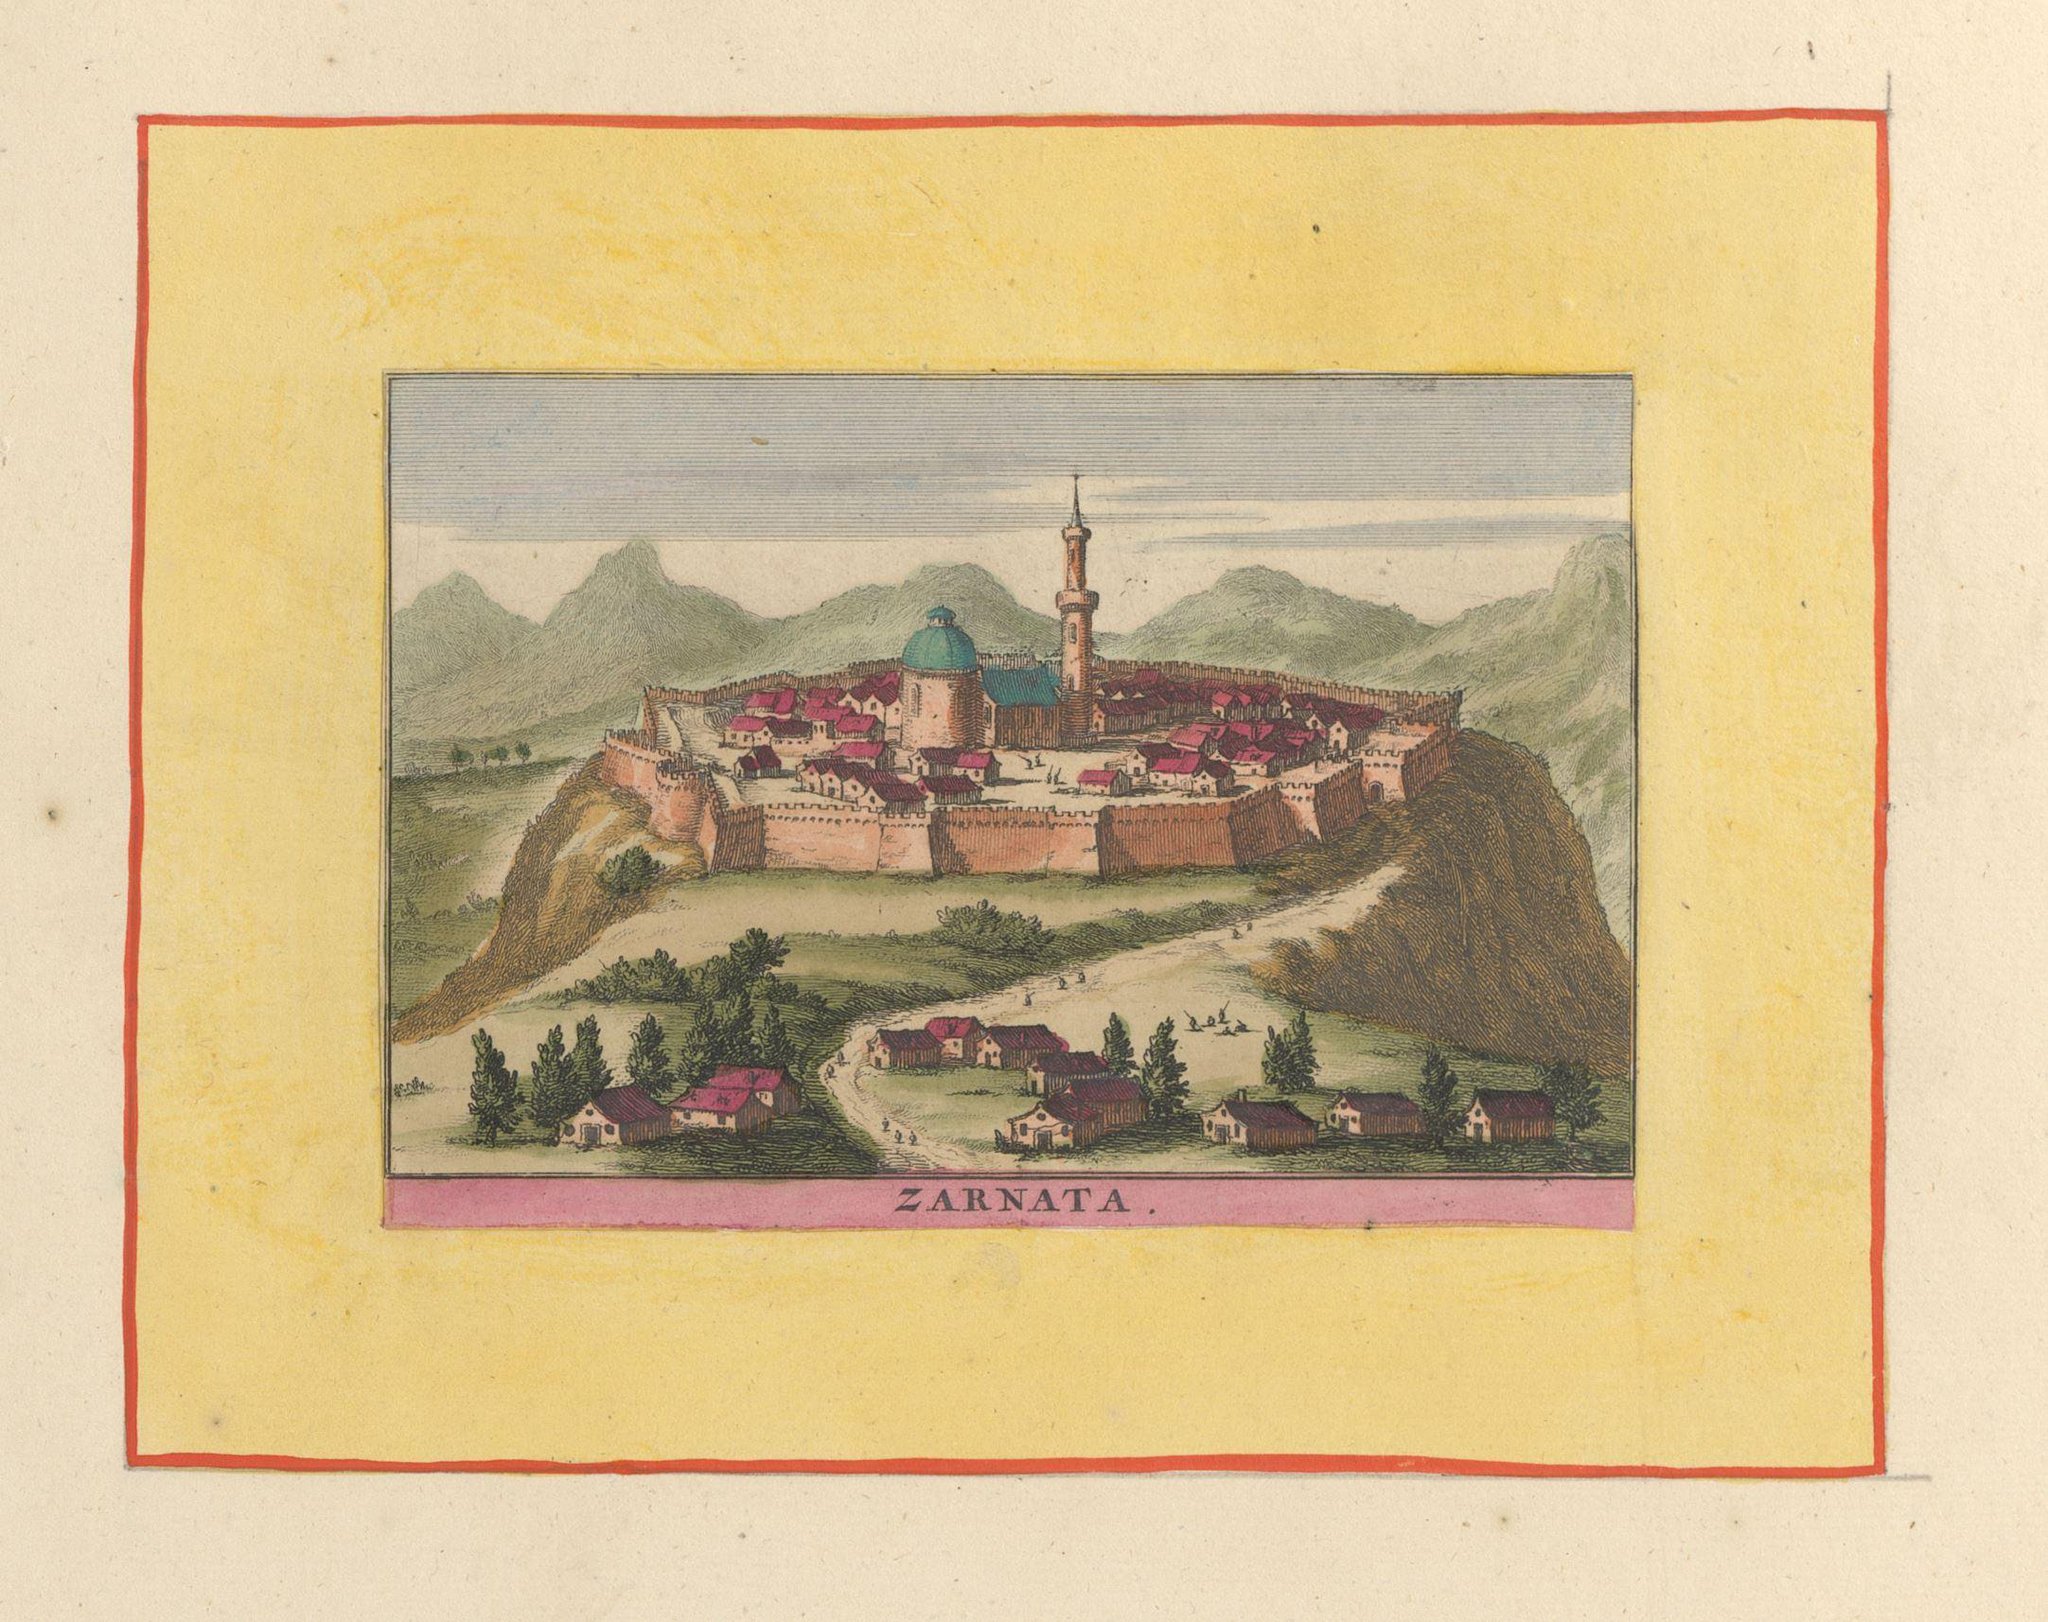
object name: print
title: Zarnata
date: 1679-1702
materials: paper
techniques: colour, etching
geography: amsterdam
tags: fortress, city-view, and landscape with man-made constructions, castle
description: Prent maakt deel uit van een set van 16 prenten met voorstellingen van Griekse vestingsteden, oorspronkelijk gedrukt op één blad, die gebruikt konden worden als sieraad rond een kaart.